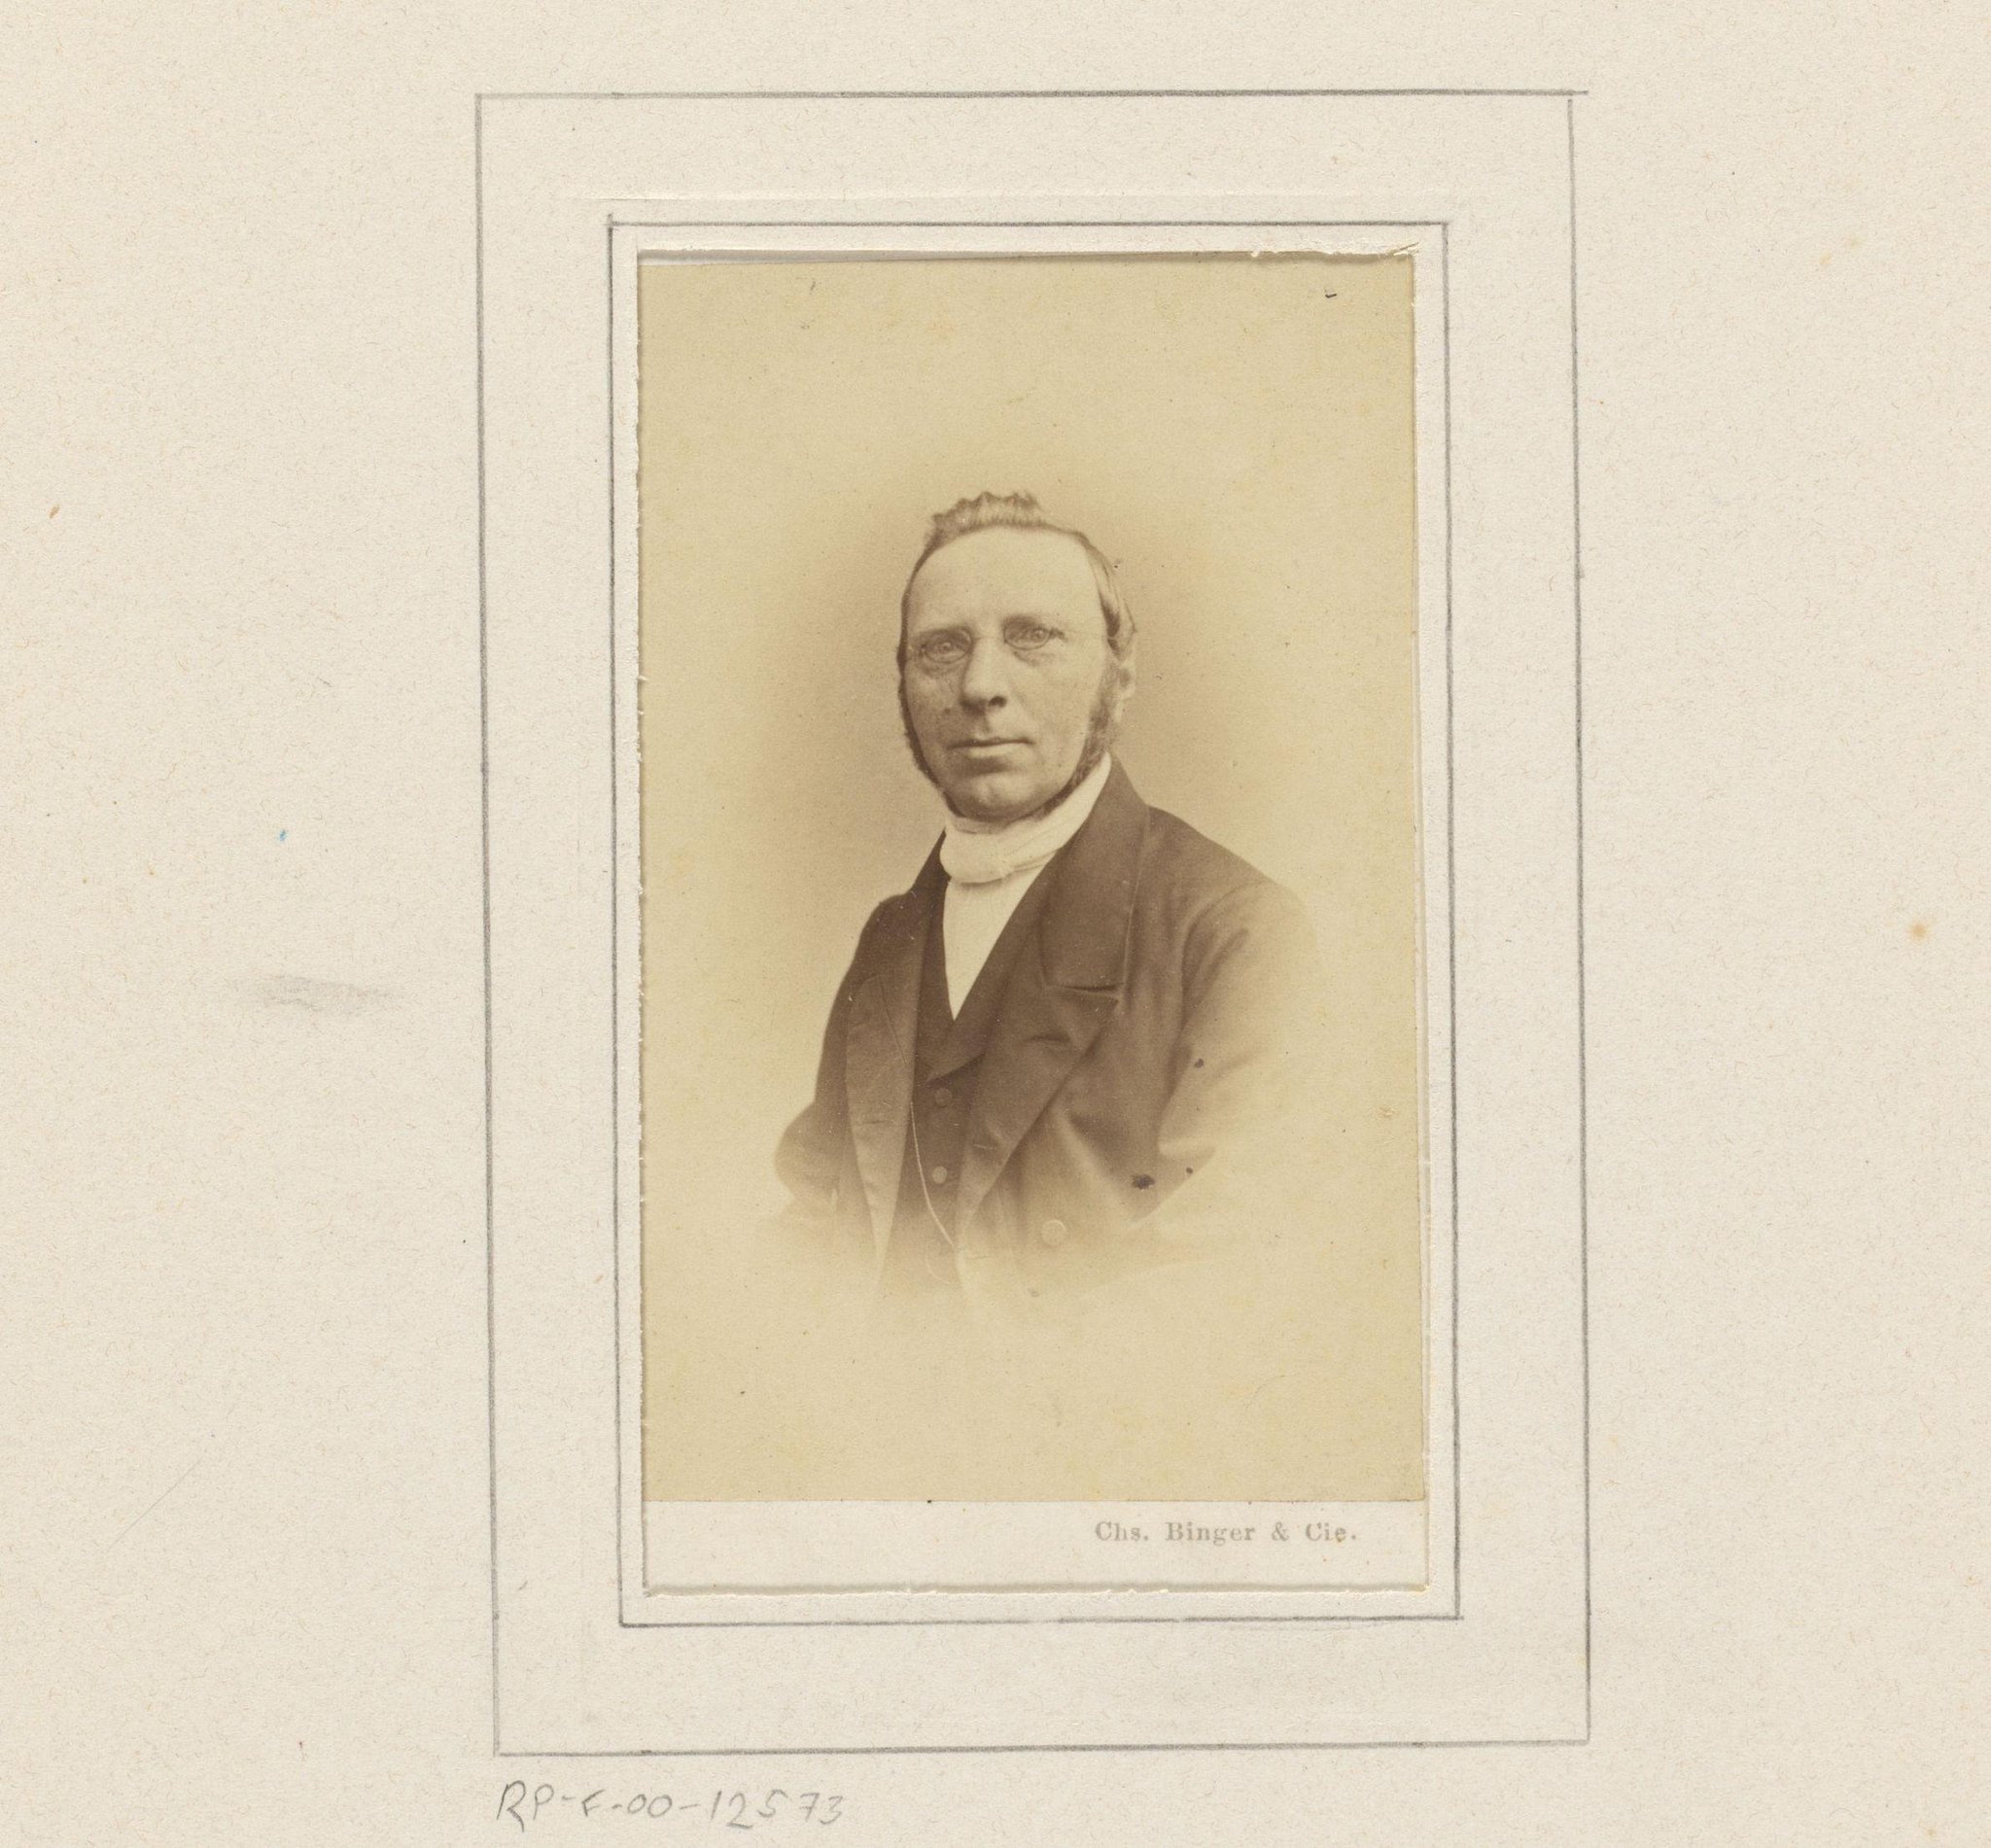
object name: carte de visite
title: Portret van Willem van Vorde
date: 1862-1869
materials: cardboard, paper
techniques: albumen print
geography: haarlem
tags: historical persons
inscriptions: address: ‘Zijlstraat/ HAARLEM.’